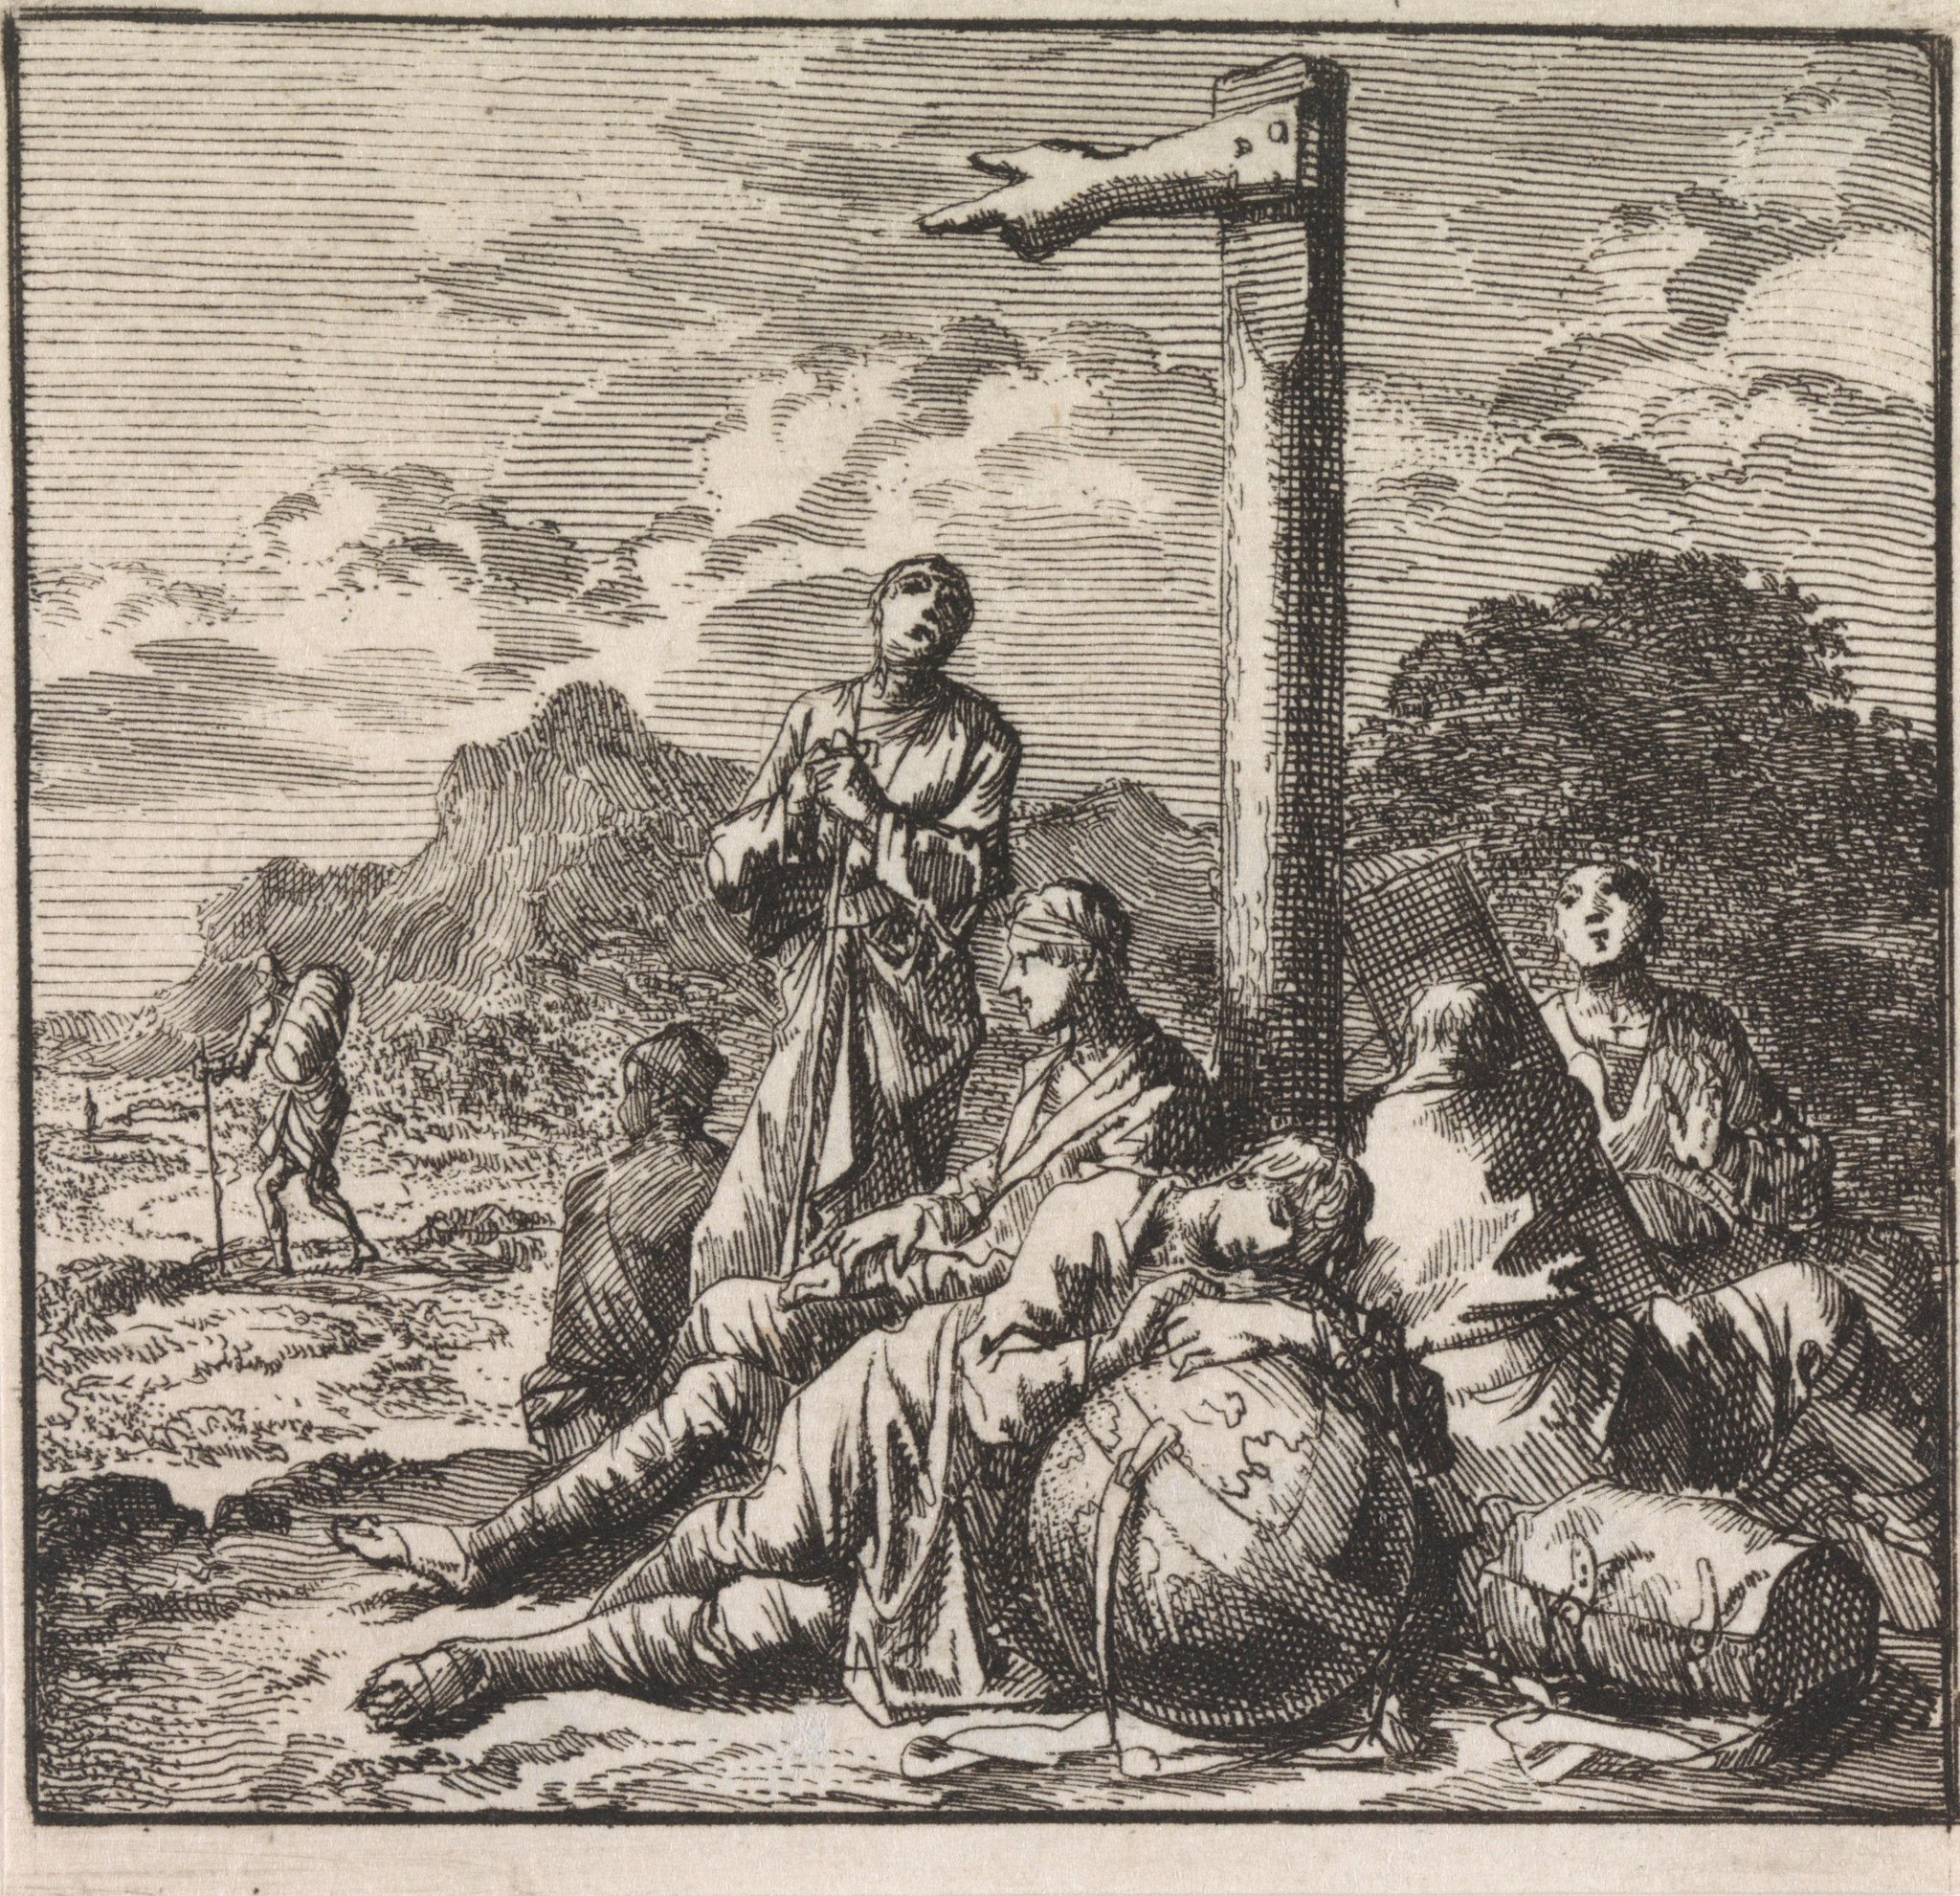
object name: print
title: Bij een wegwijzer zitten zes figuren met de wereld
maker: jan luyken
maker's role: draughtsman, print maker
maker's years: 1649-1712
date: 1710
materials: paper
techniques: etching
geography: amsterdam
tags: earth, world as celestial body, signpost, resting - bb - out of doors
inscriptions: collector's mark: Lugt 2228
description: Proefdruk voor illustratie uit: Luyken, Jan. De onwaardige wereld, vertoond in vyftig zinnebeelden, met godlyke spreuken en stichtelyke verzen. Amsterdam: Pieter Arentsz. II (wed.) en Cornelis van der Sys, 1710, p. 128.